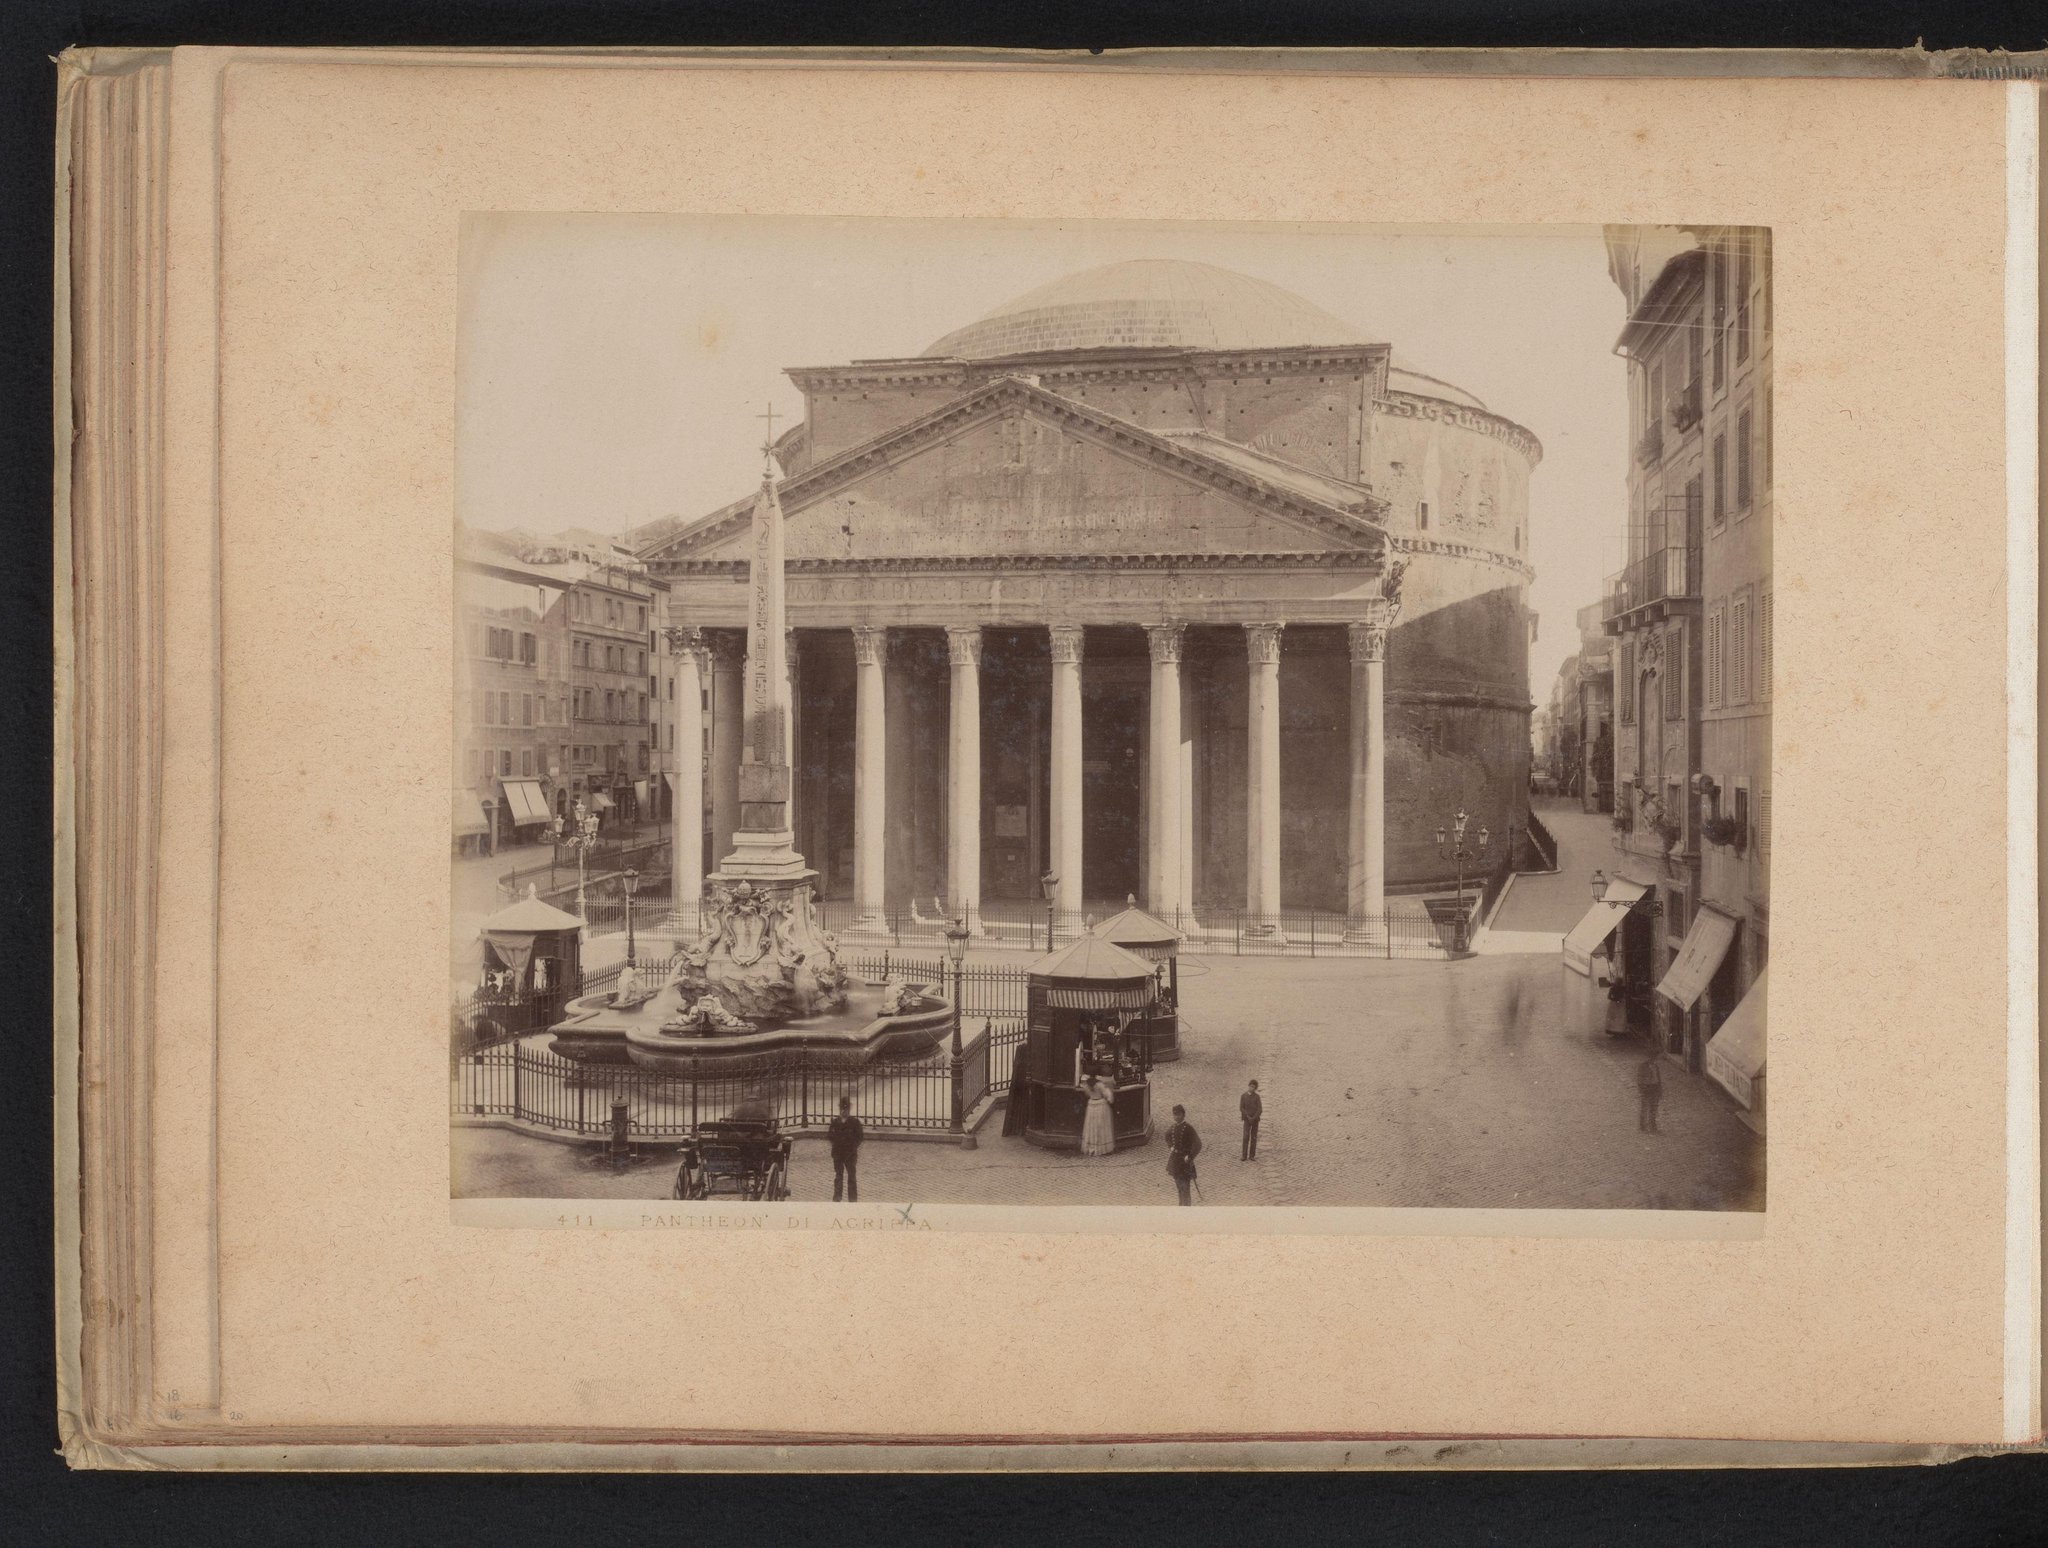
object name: photograph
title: Gezicht op het Pantheon in Rome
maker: Anonymous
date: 1870-1895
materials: cardboard, photographic support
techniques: albumen print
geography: rome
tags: temple, shrine ~ non-christian religions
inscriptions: inscription: ‘411 PANTHEON DI AGRIPPA’